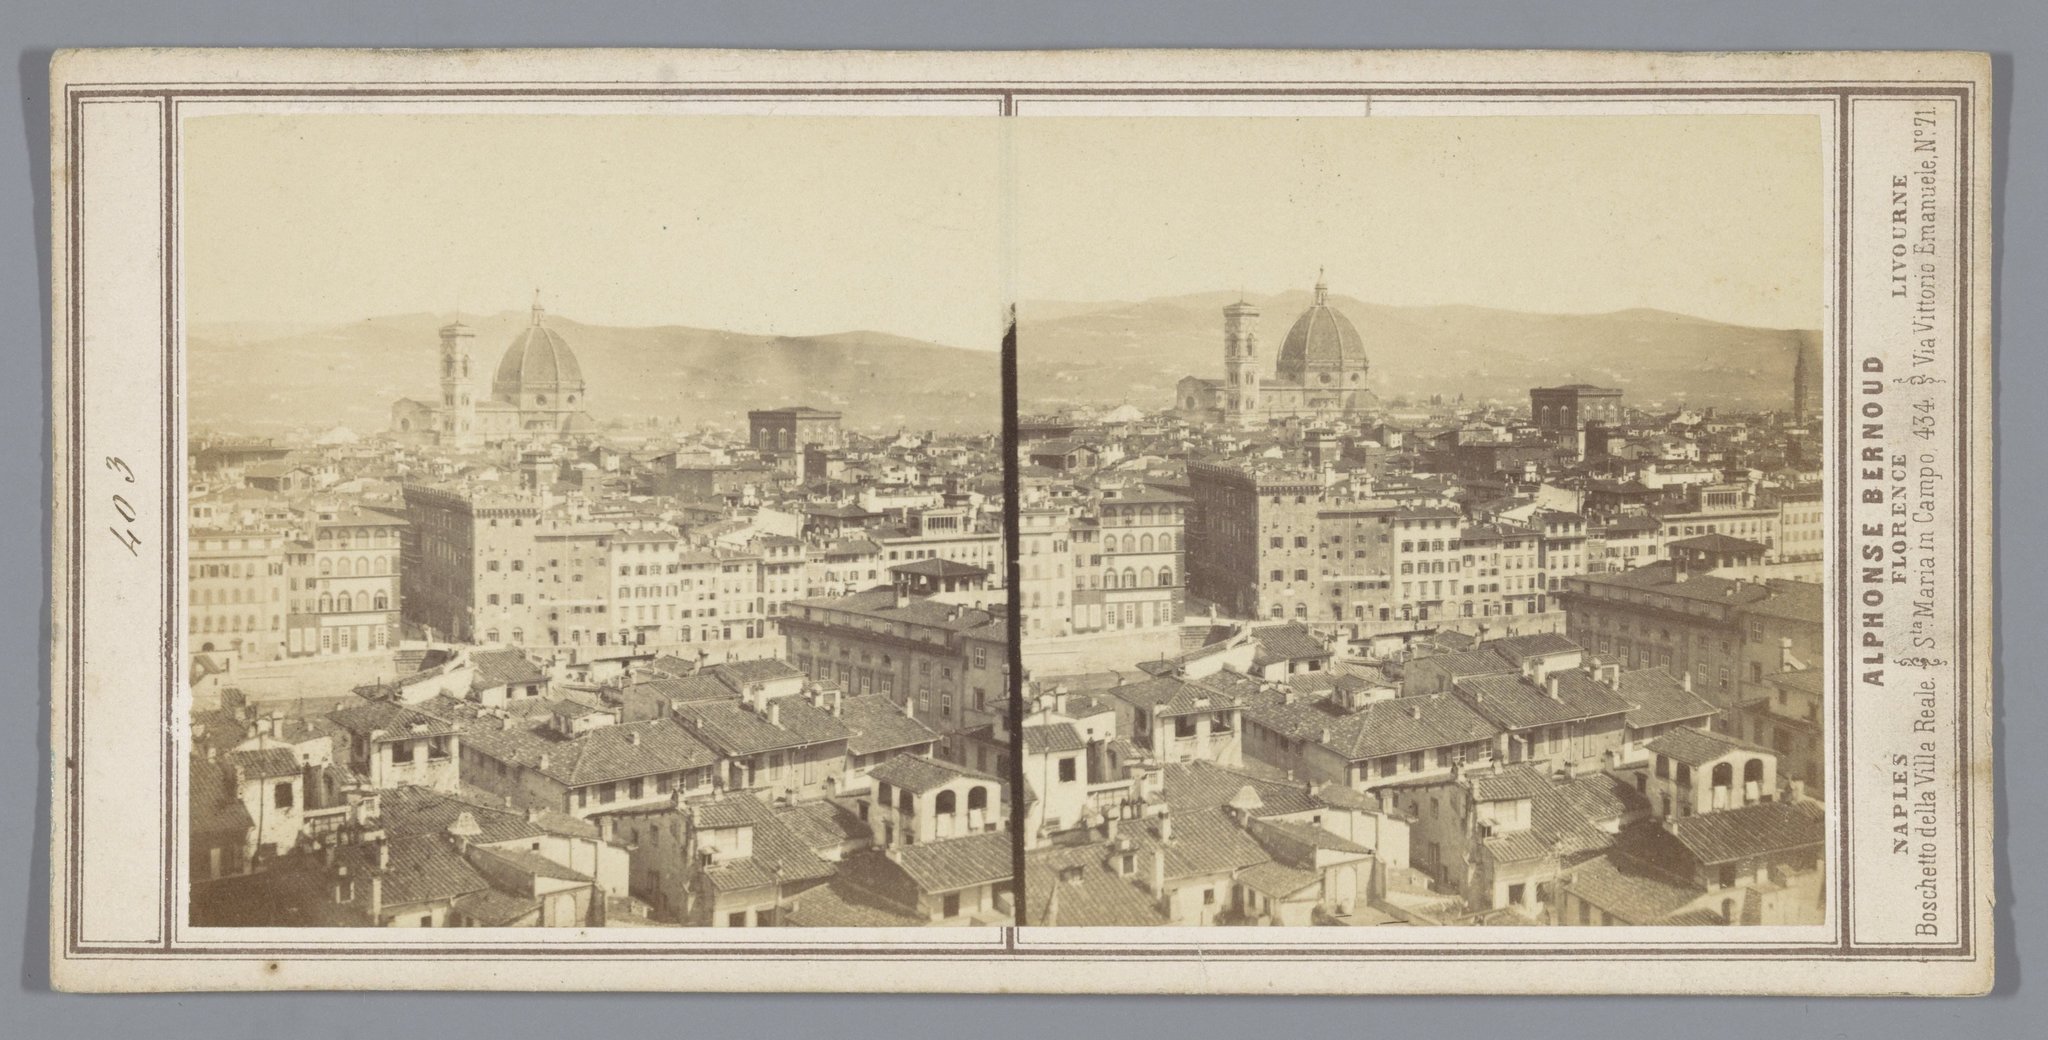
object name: stereograph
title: Gezicht op Florence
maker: alphonse bernoud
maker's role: fotograaf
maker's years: 1820-1889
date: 1850-1880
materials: cardboard, photographic support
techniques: albumen print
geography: florence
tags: city-view in general; 'veduta'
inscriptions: number: ‘403’, inscription: ‘Panorama [...] da S. Spirito’, name: ‘ALPHONSE BERNOUD NAPLES Boschetto della Villa Reale. FLORENCE Sta. Maria in Campo, 434. LIVOURNE Via Vittorio Emanuele, No. 71.’